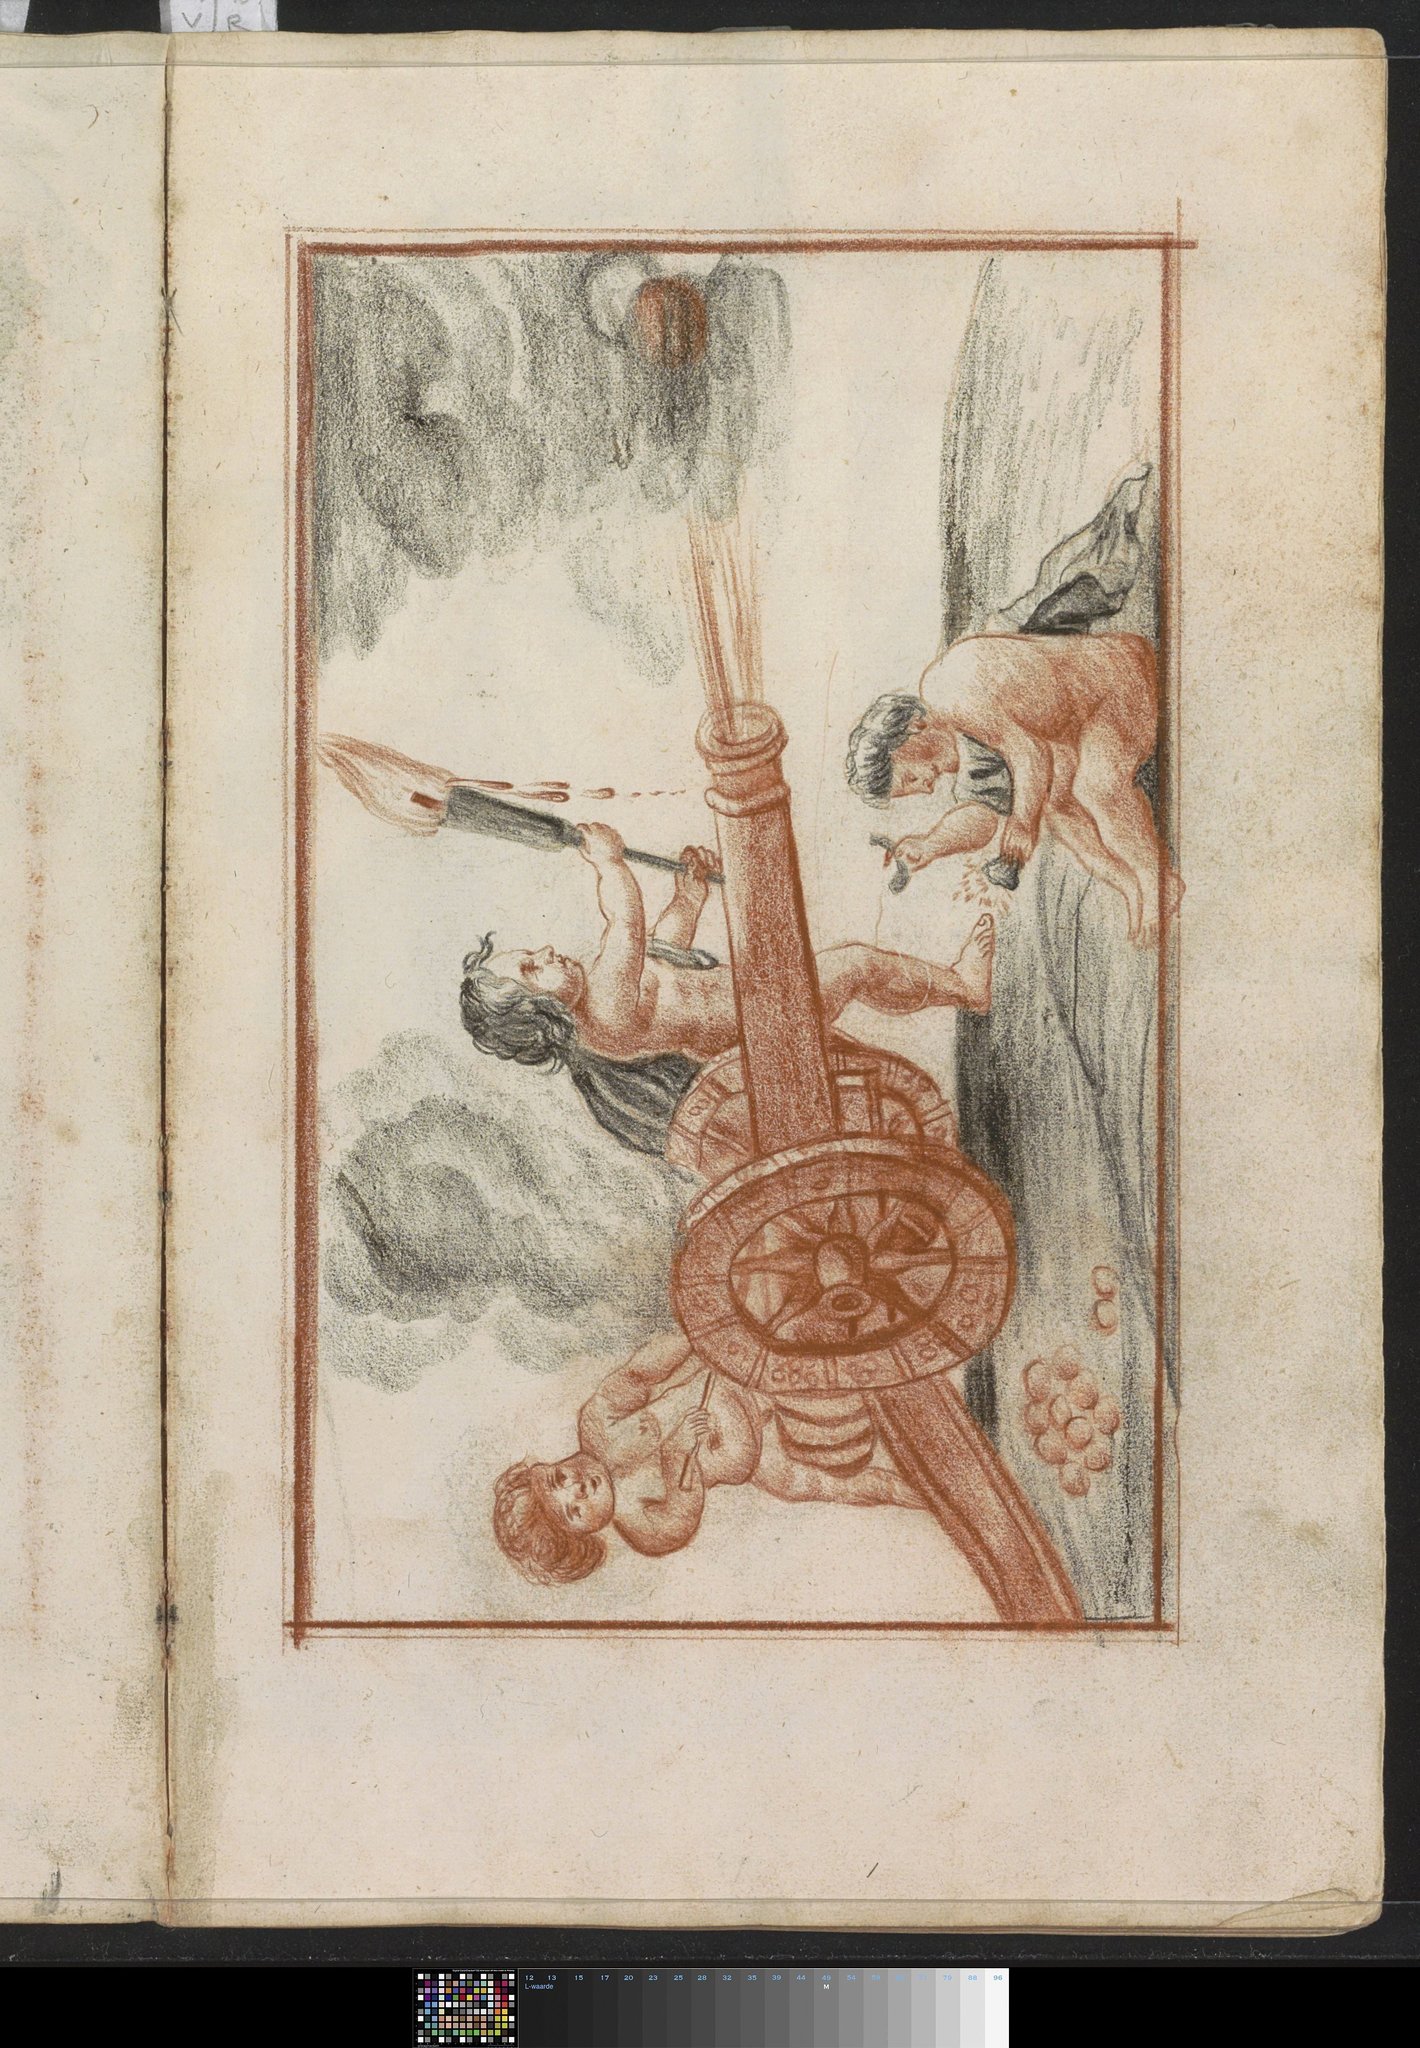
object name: sketchbook leaf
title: Putti die een kanon afschieten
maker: hendrick van beaumont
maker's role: draughtsman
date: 1696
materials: chalk, paper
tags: firearms: cannon, cupids: 'amores', 'amoretti', 'putti'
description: Vermoedelijk een verbeelding van het element vuur. Blad 44 recto uit een schetsboek met 91 bladen.